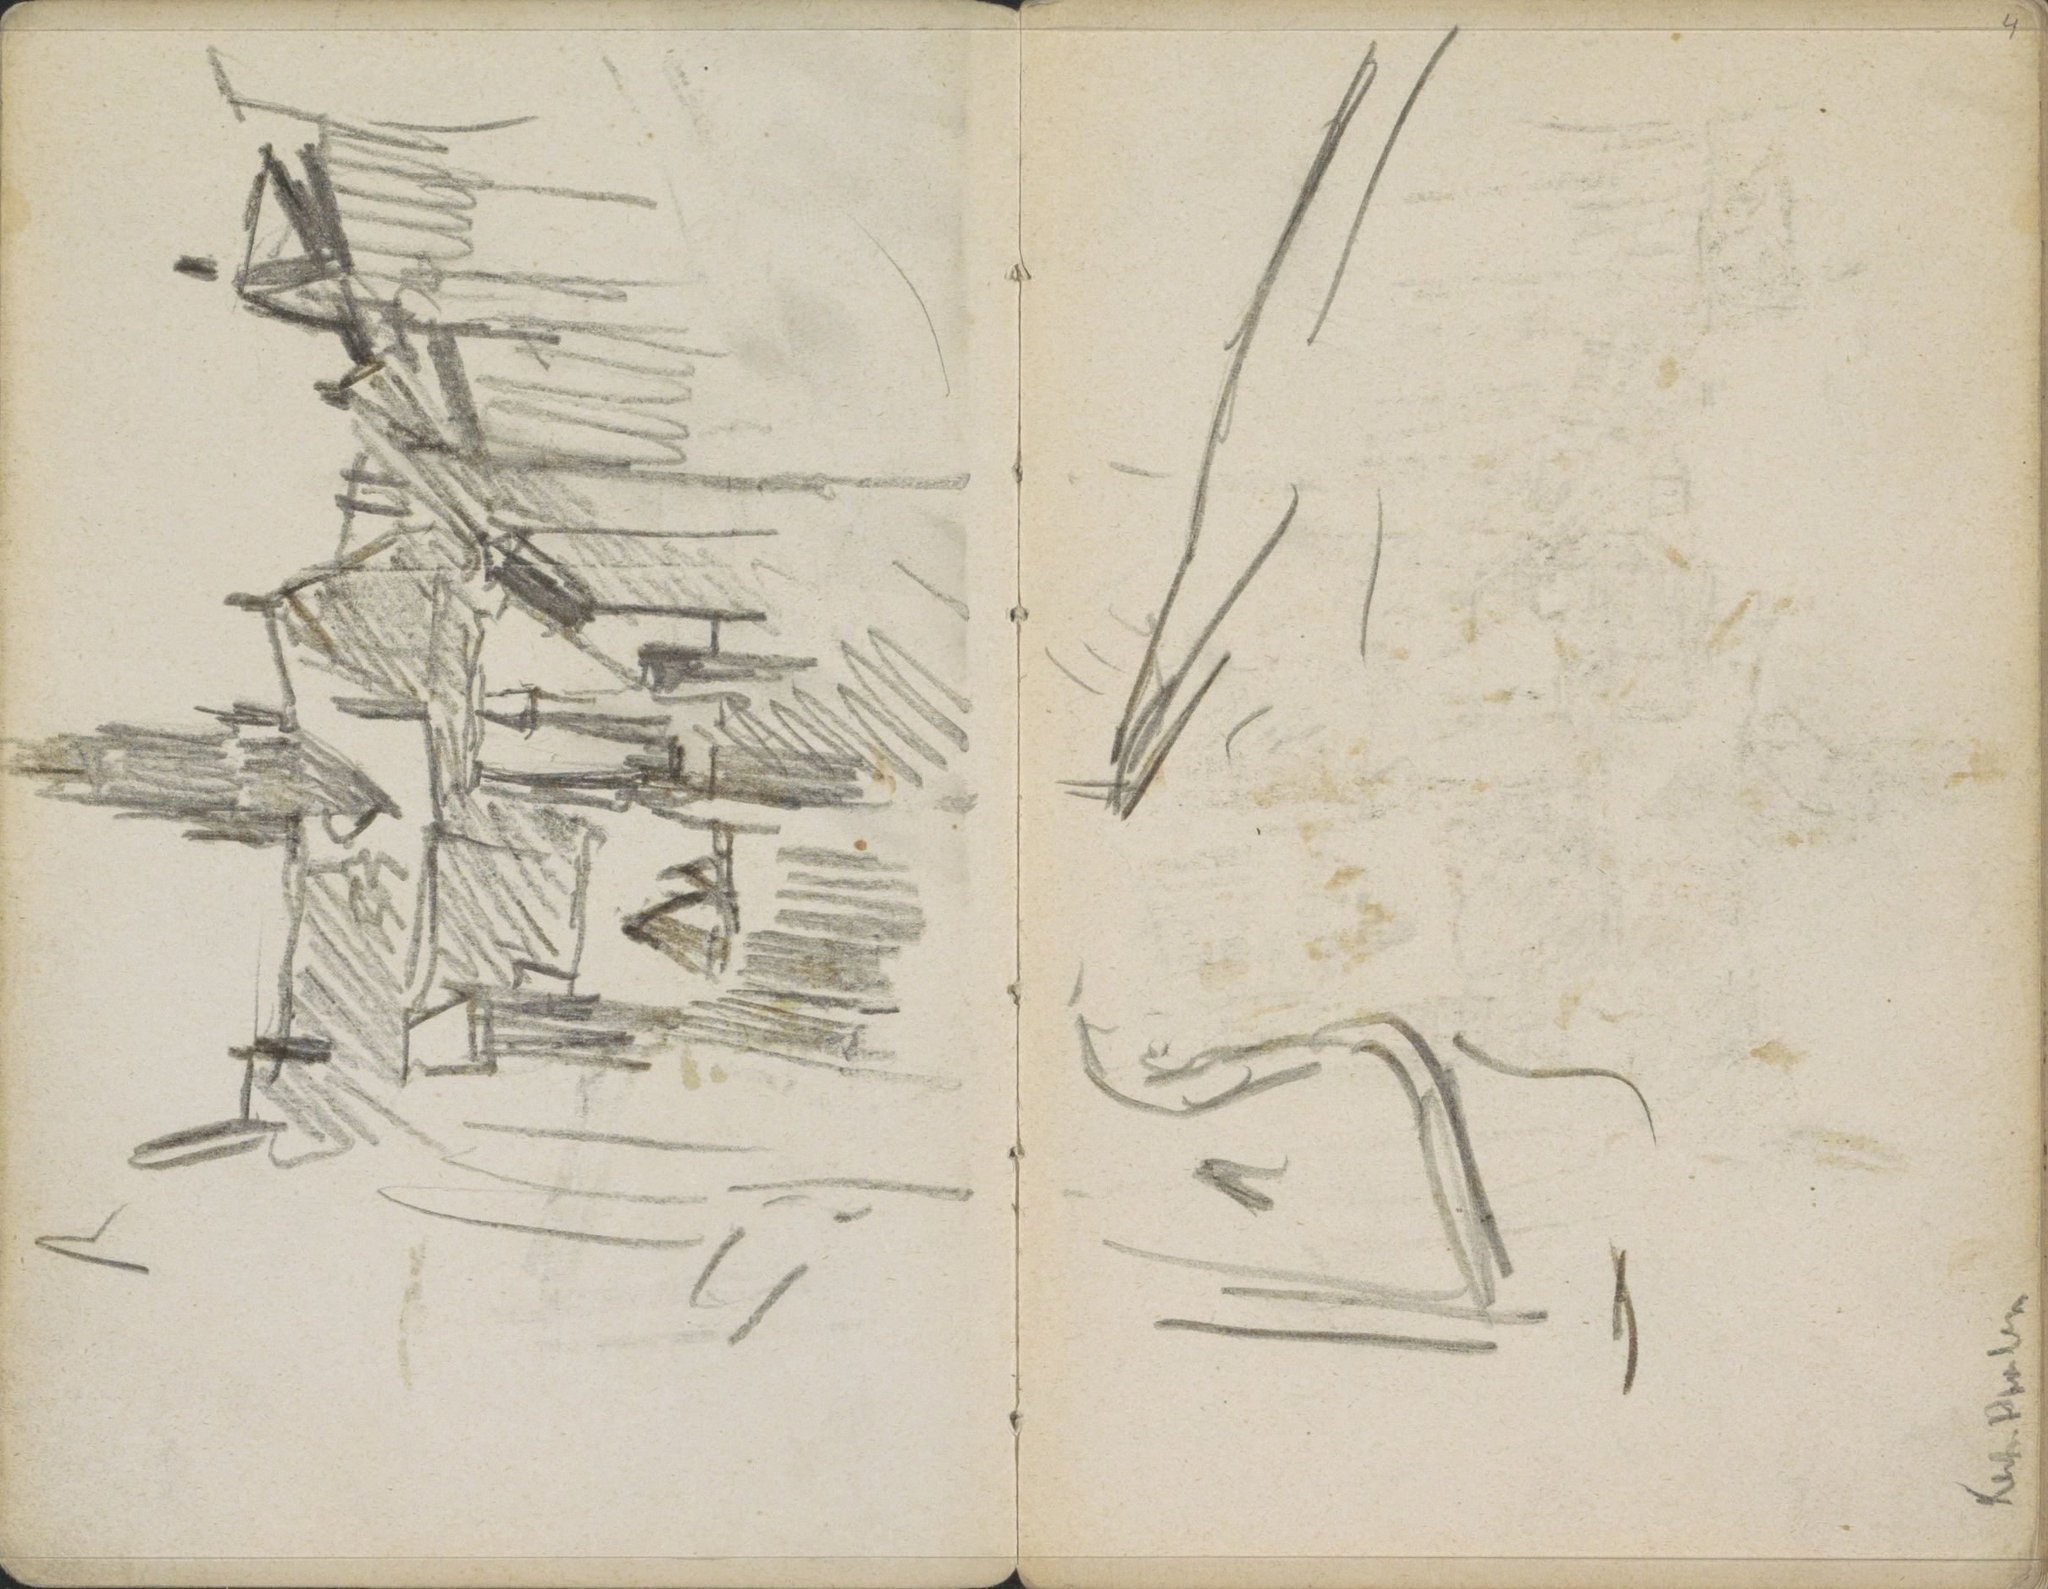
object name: sketchbook leaf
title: Sint-Bavokerk te Haarlem, gezien vanuit de Jansstraat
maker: george hendrik breitner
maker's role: draughtsman, painter, print maker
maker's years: 1857-1923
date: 1886-1908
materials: paper, pencil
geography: haarlem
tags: church (exterior), street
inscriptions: annotation: ‘Kerk Haarlem’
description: Pagina 3 en pagina 4 uit een schetsboek met 46 bladen vervaardigd te Amsterdam, Haarlem en Antwerpen.